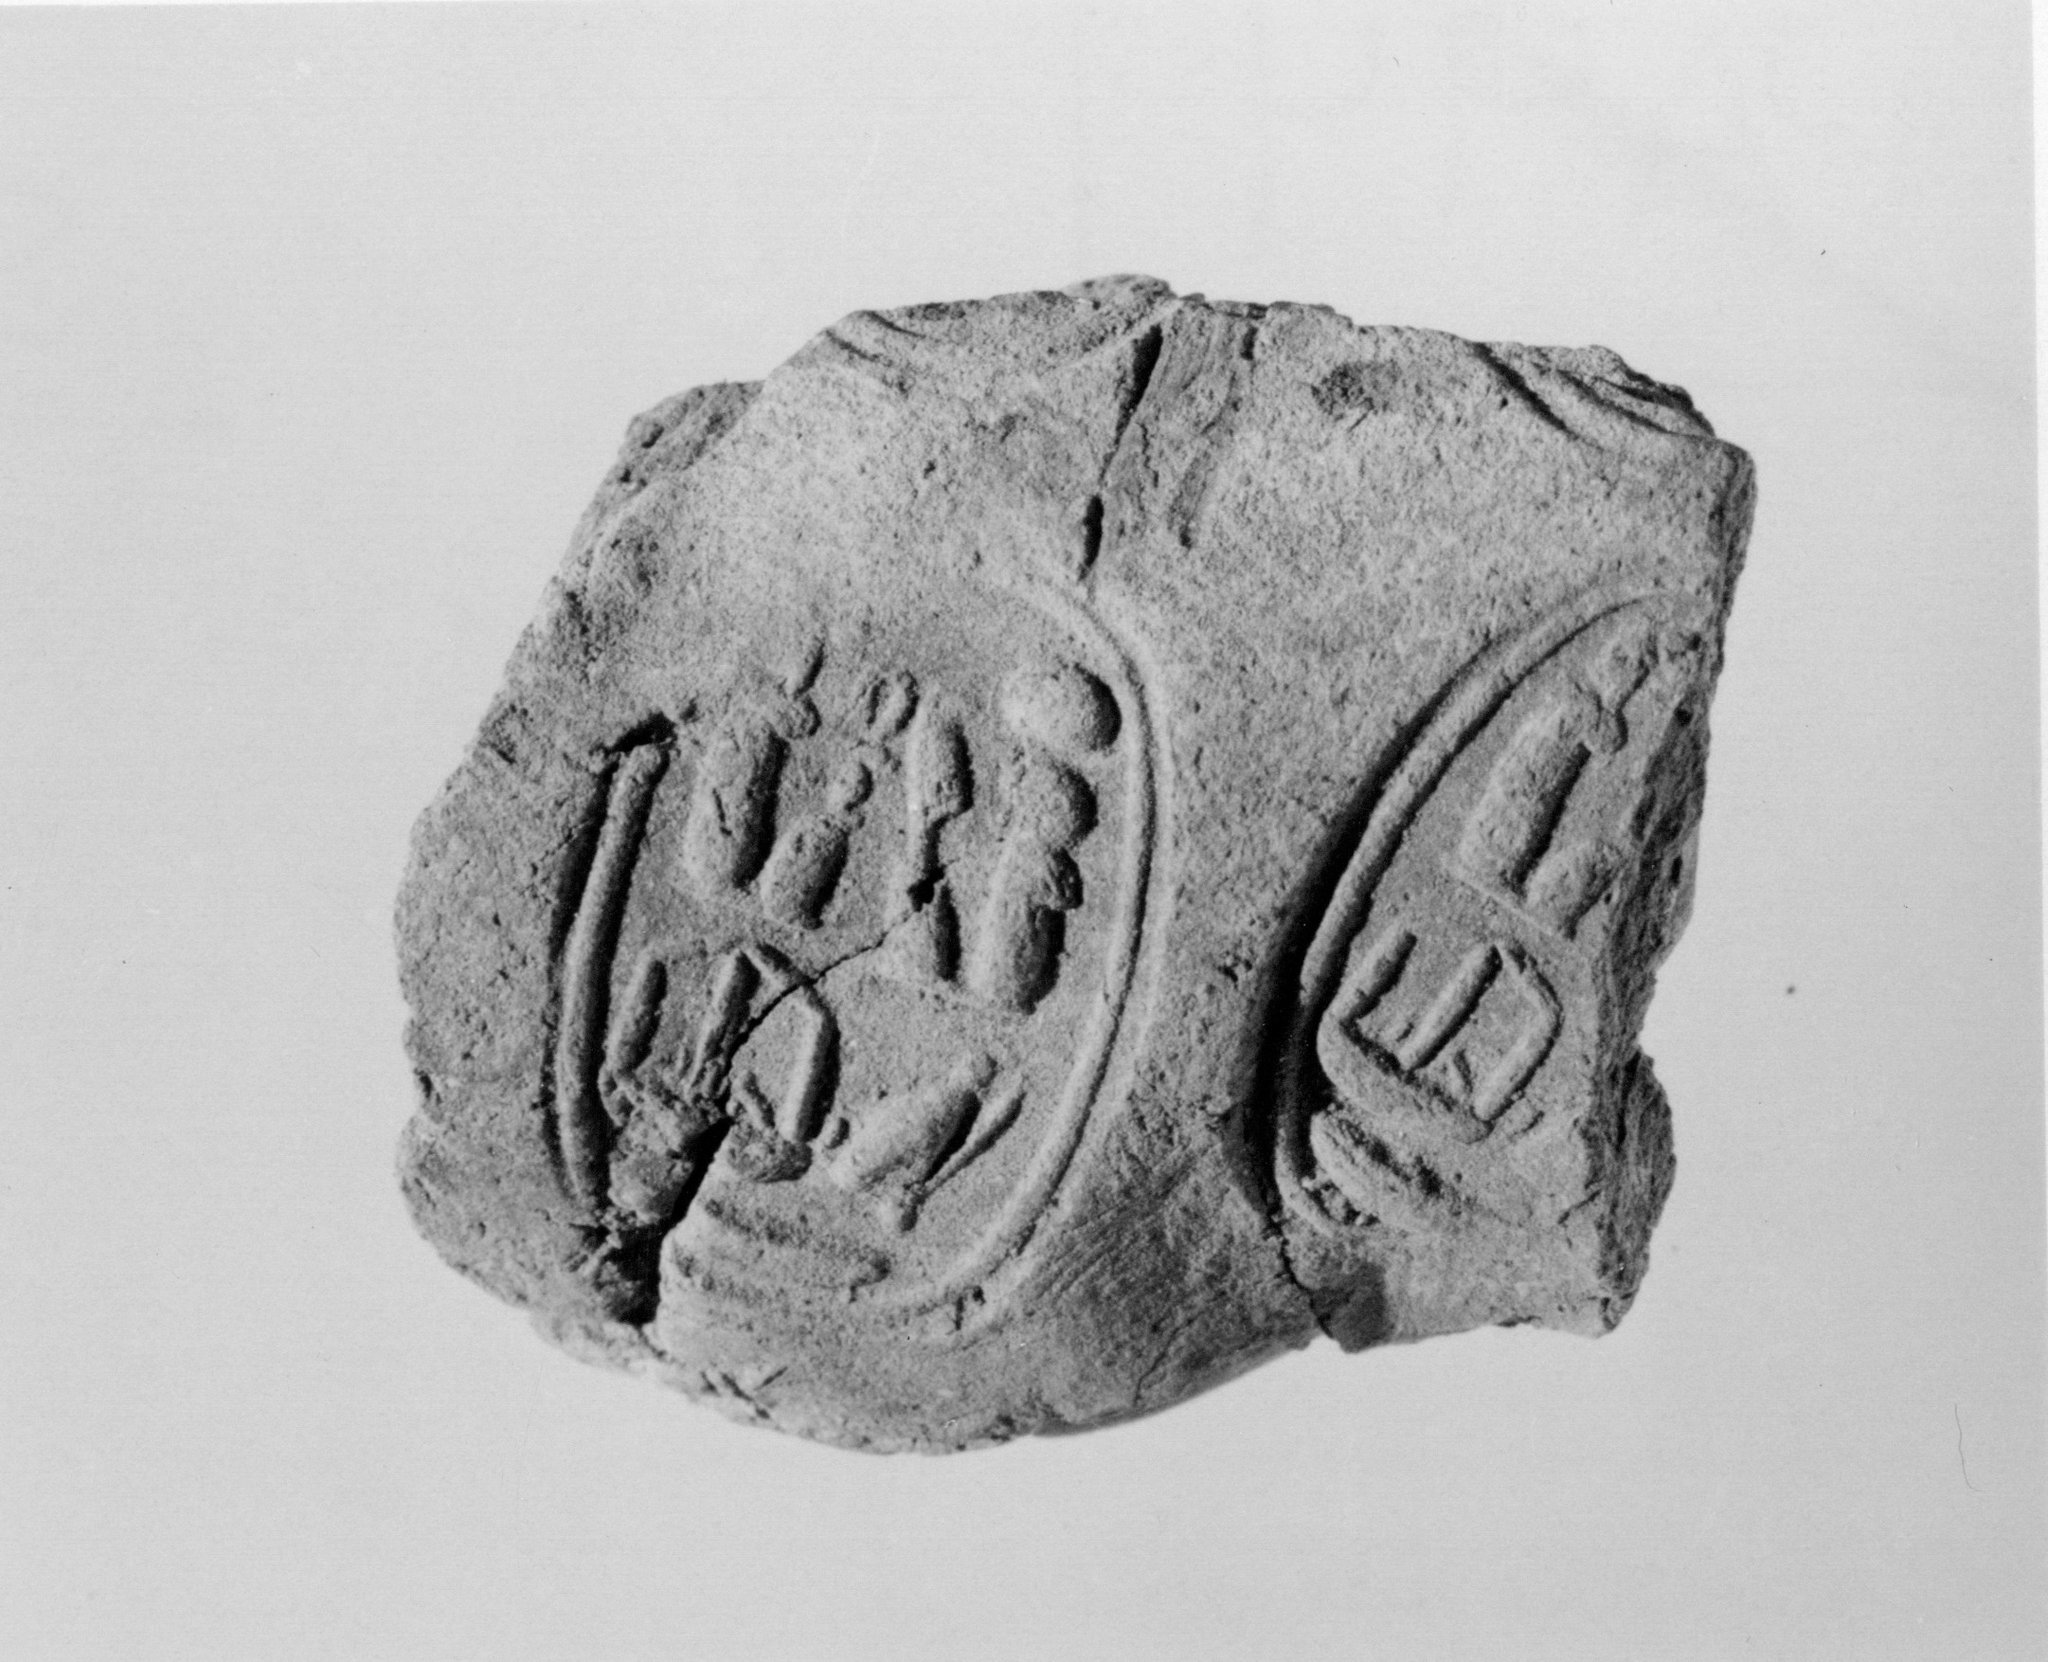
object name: sealing, nebmaatre, amenhotep iii, heb sed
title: Document Sealing With the Throne Name of Amenhotep III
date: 1390-1352 BCE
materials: mud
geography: egypt